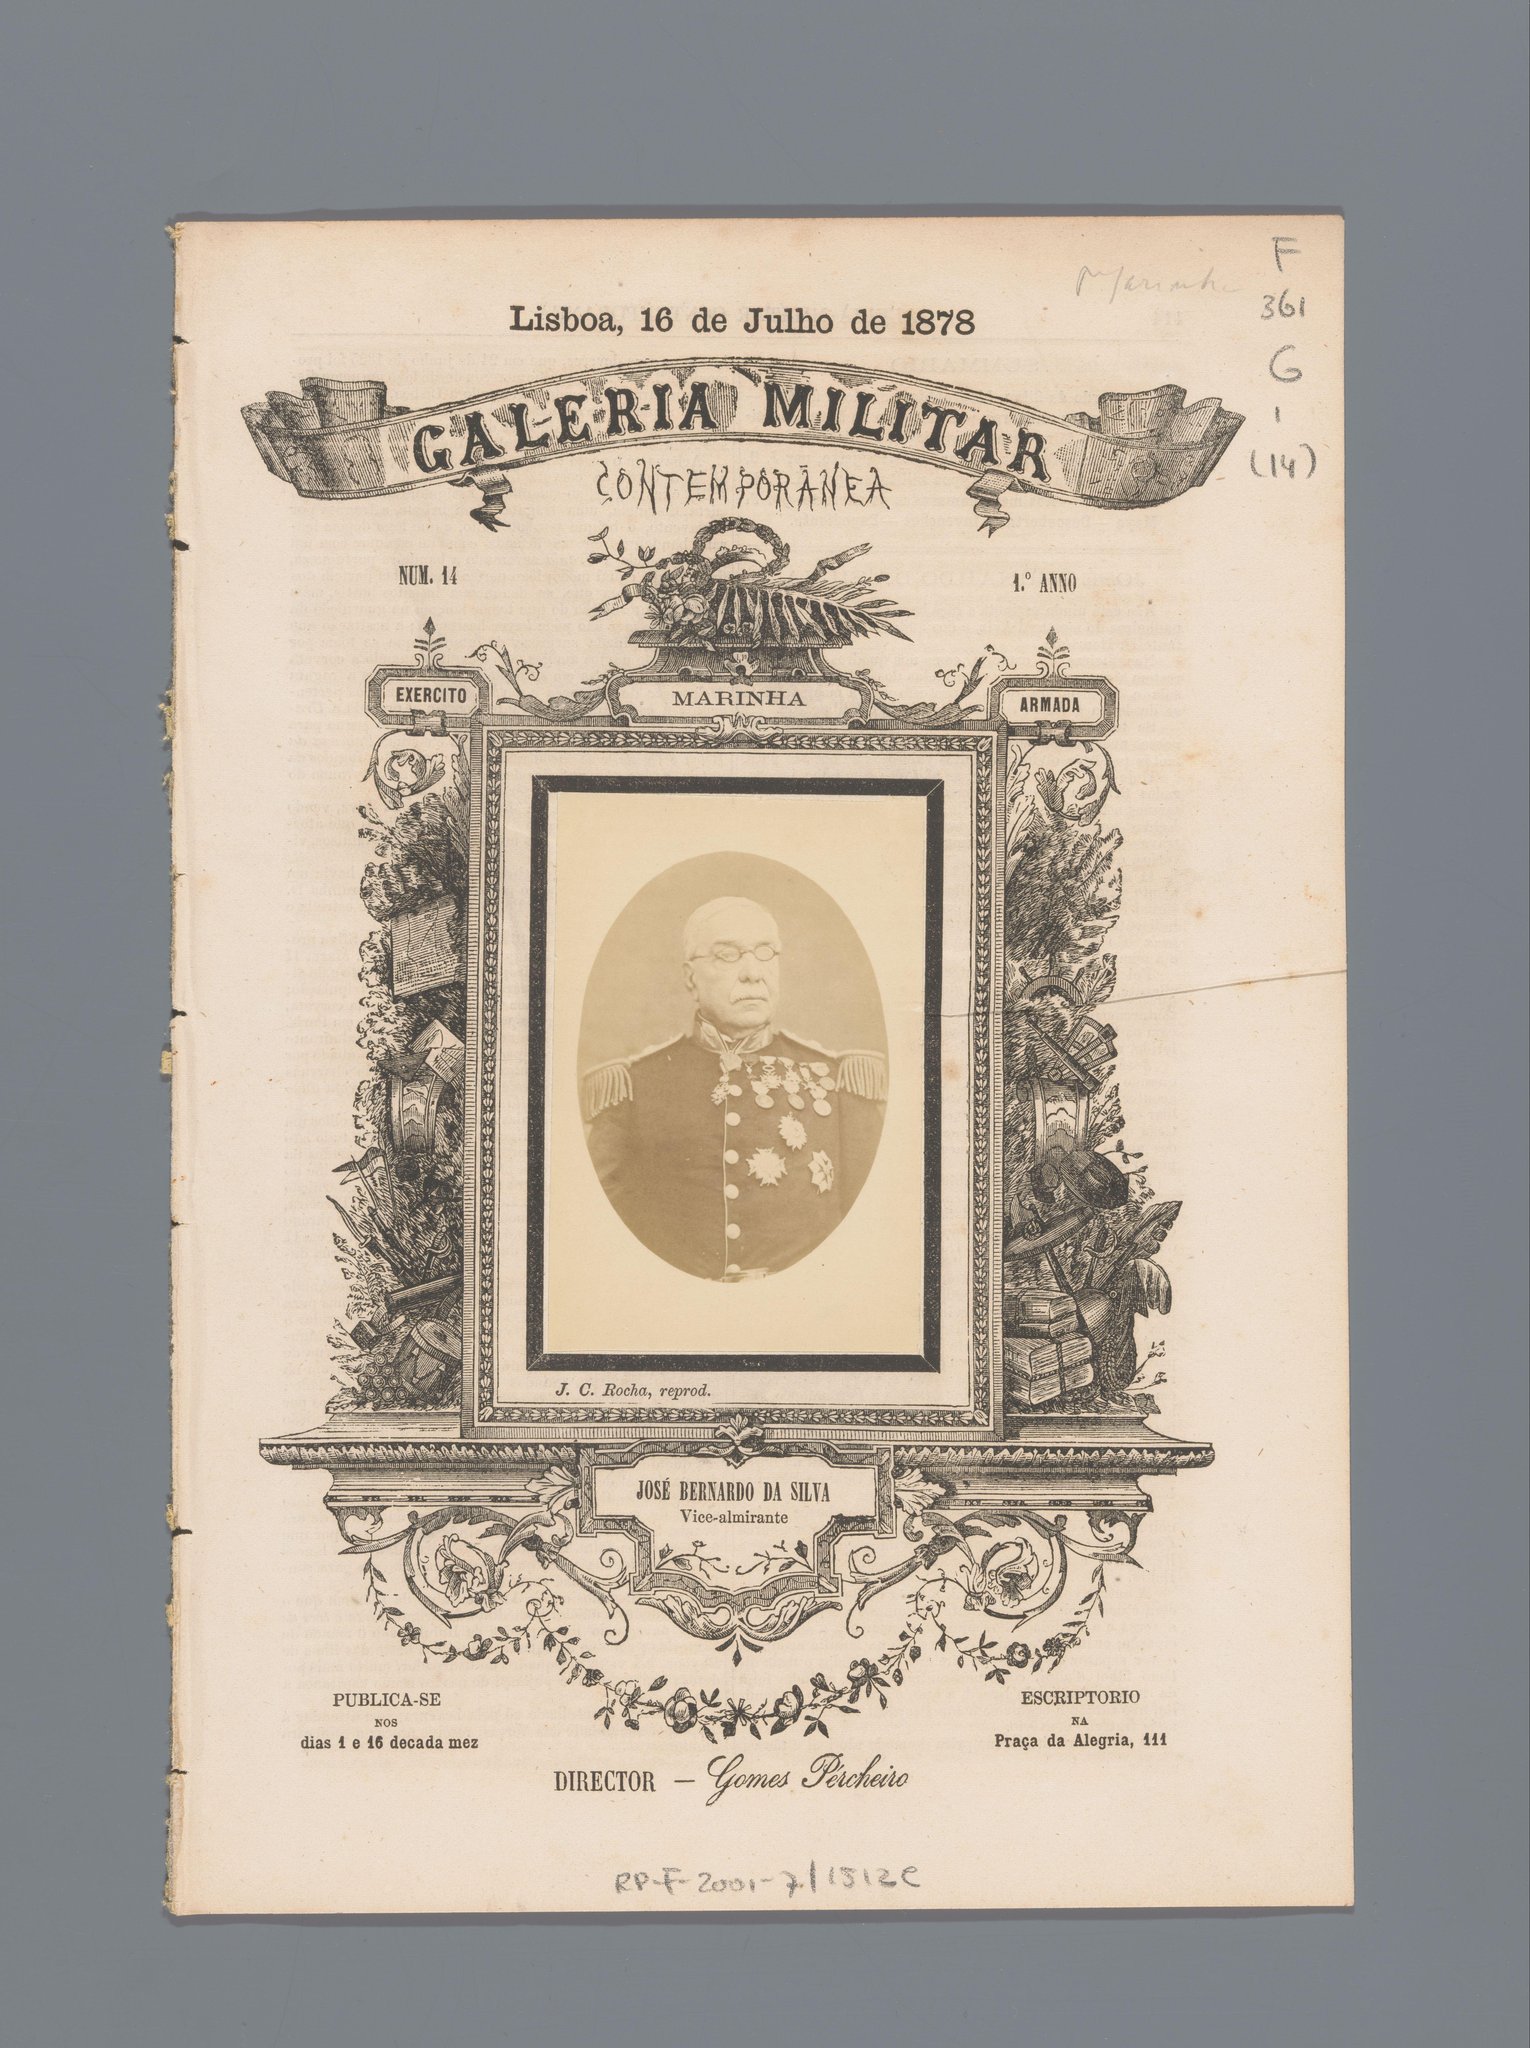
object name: book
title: Galeria militar contemporanea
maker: gomes pércheiro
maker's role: publisher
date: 1878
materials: paper, photographic support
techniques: albumen print, printing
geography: lisbon